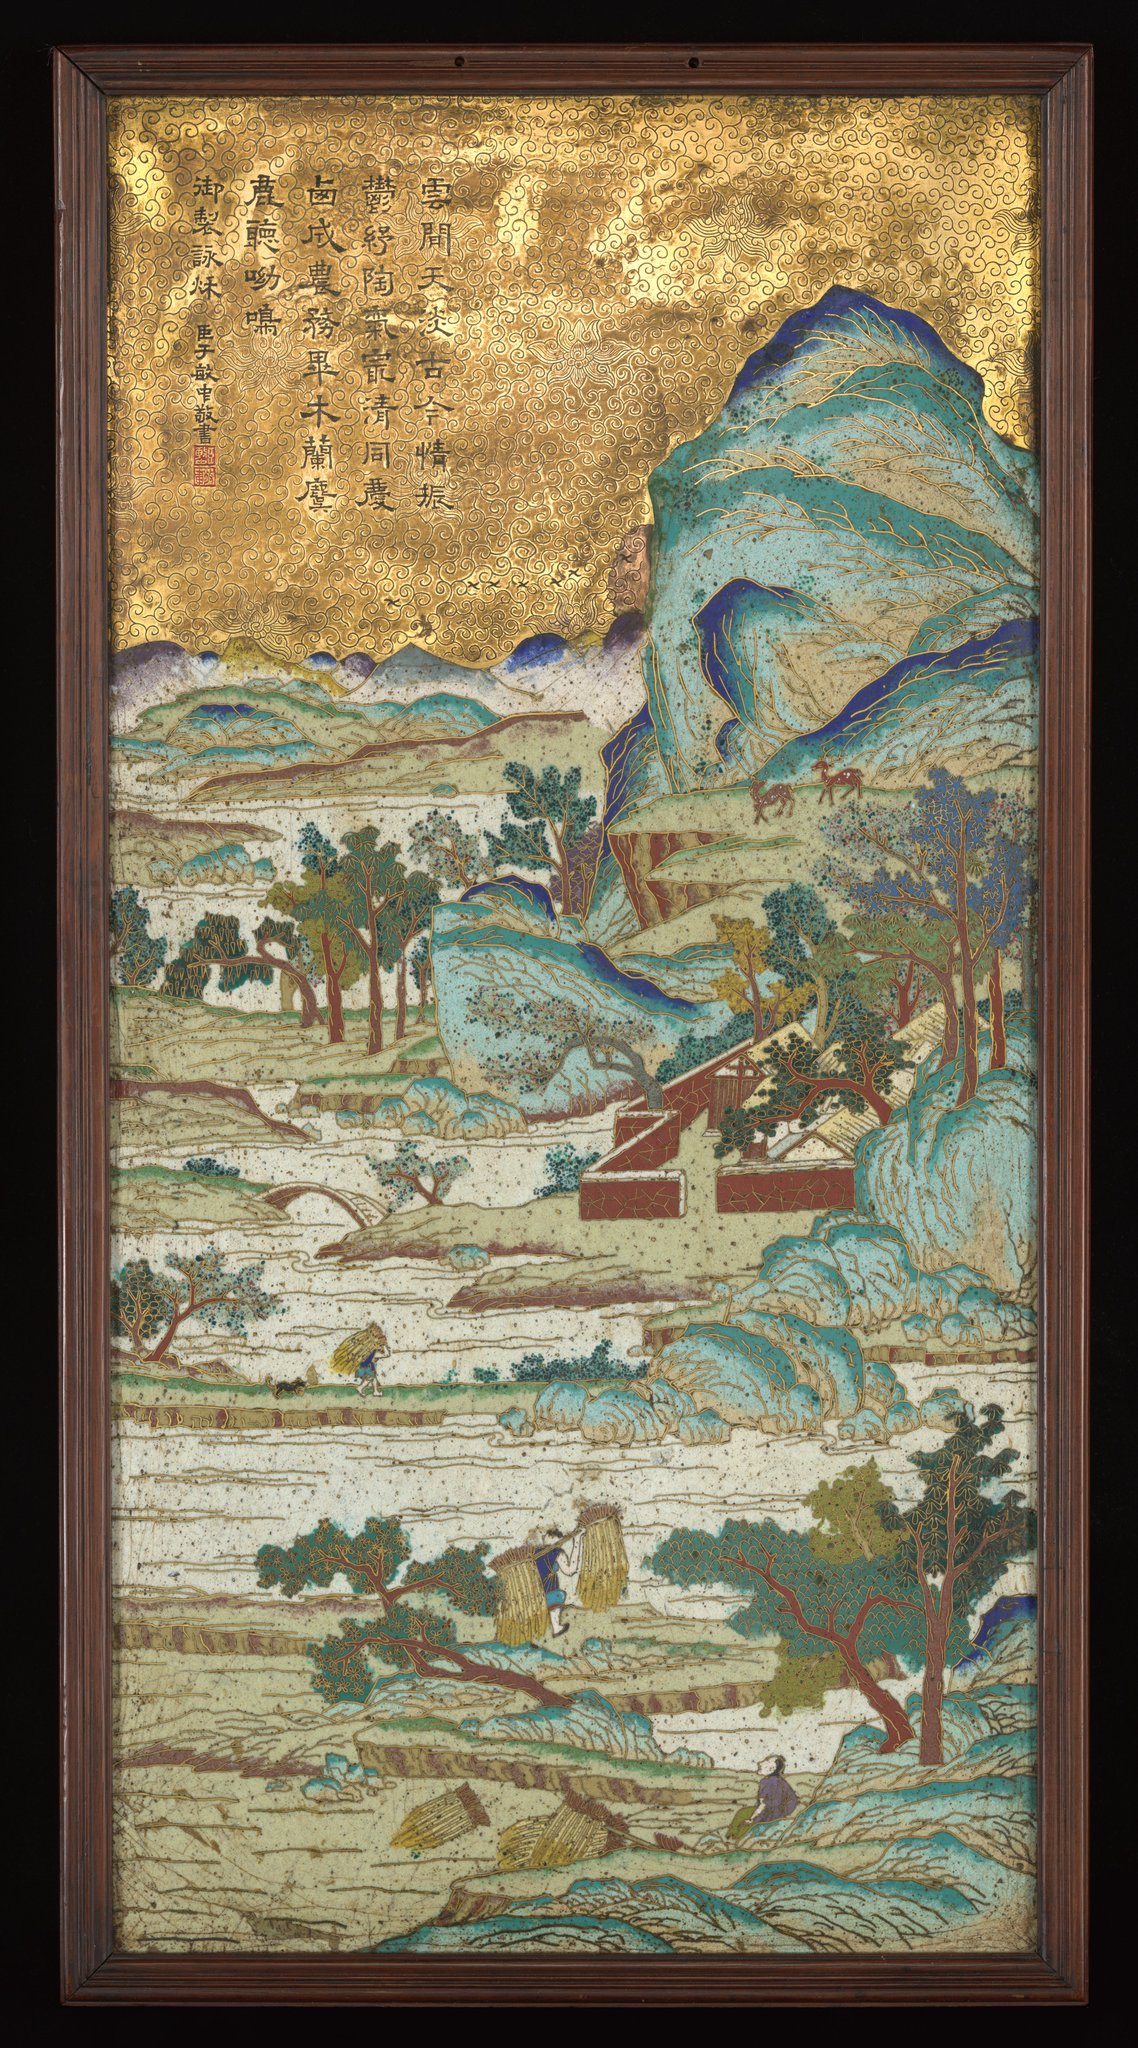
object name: wall panel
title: Wall panel with poetic scenery of autumn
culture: chinese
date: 1767-1800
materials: enamel, gilt bronze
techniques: enamel